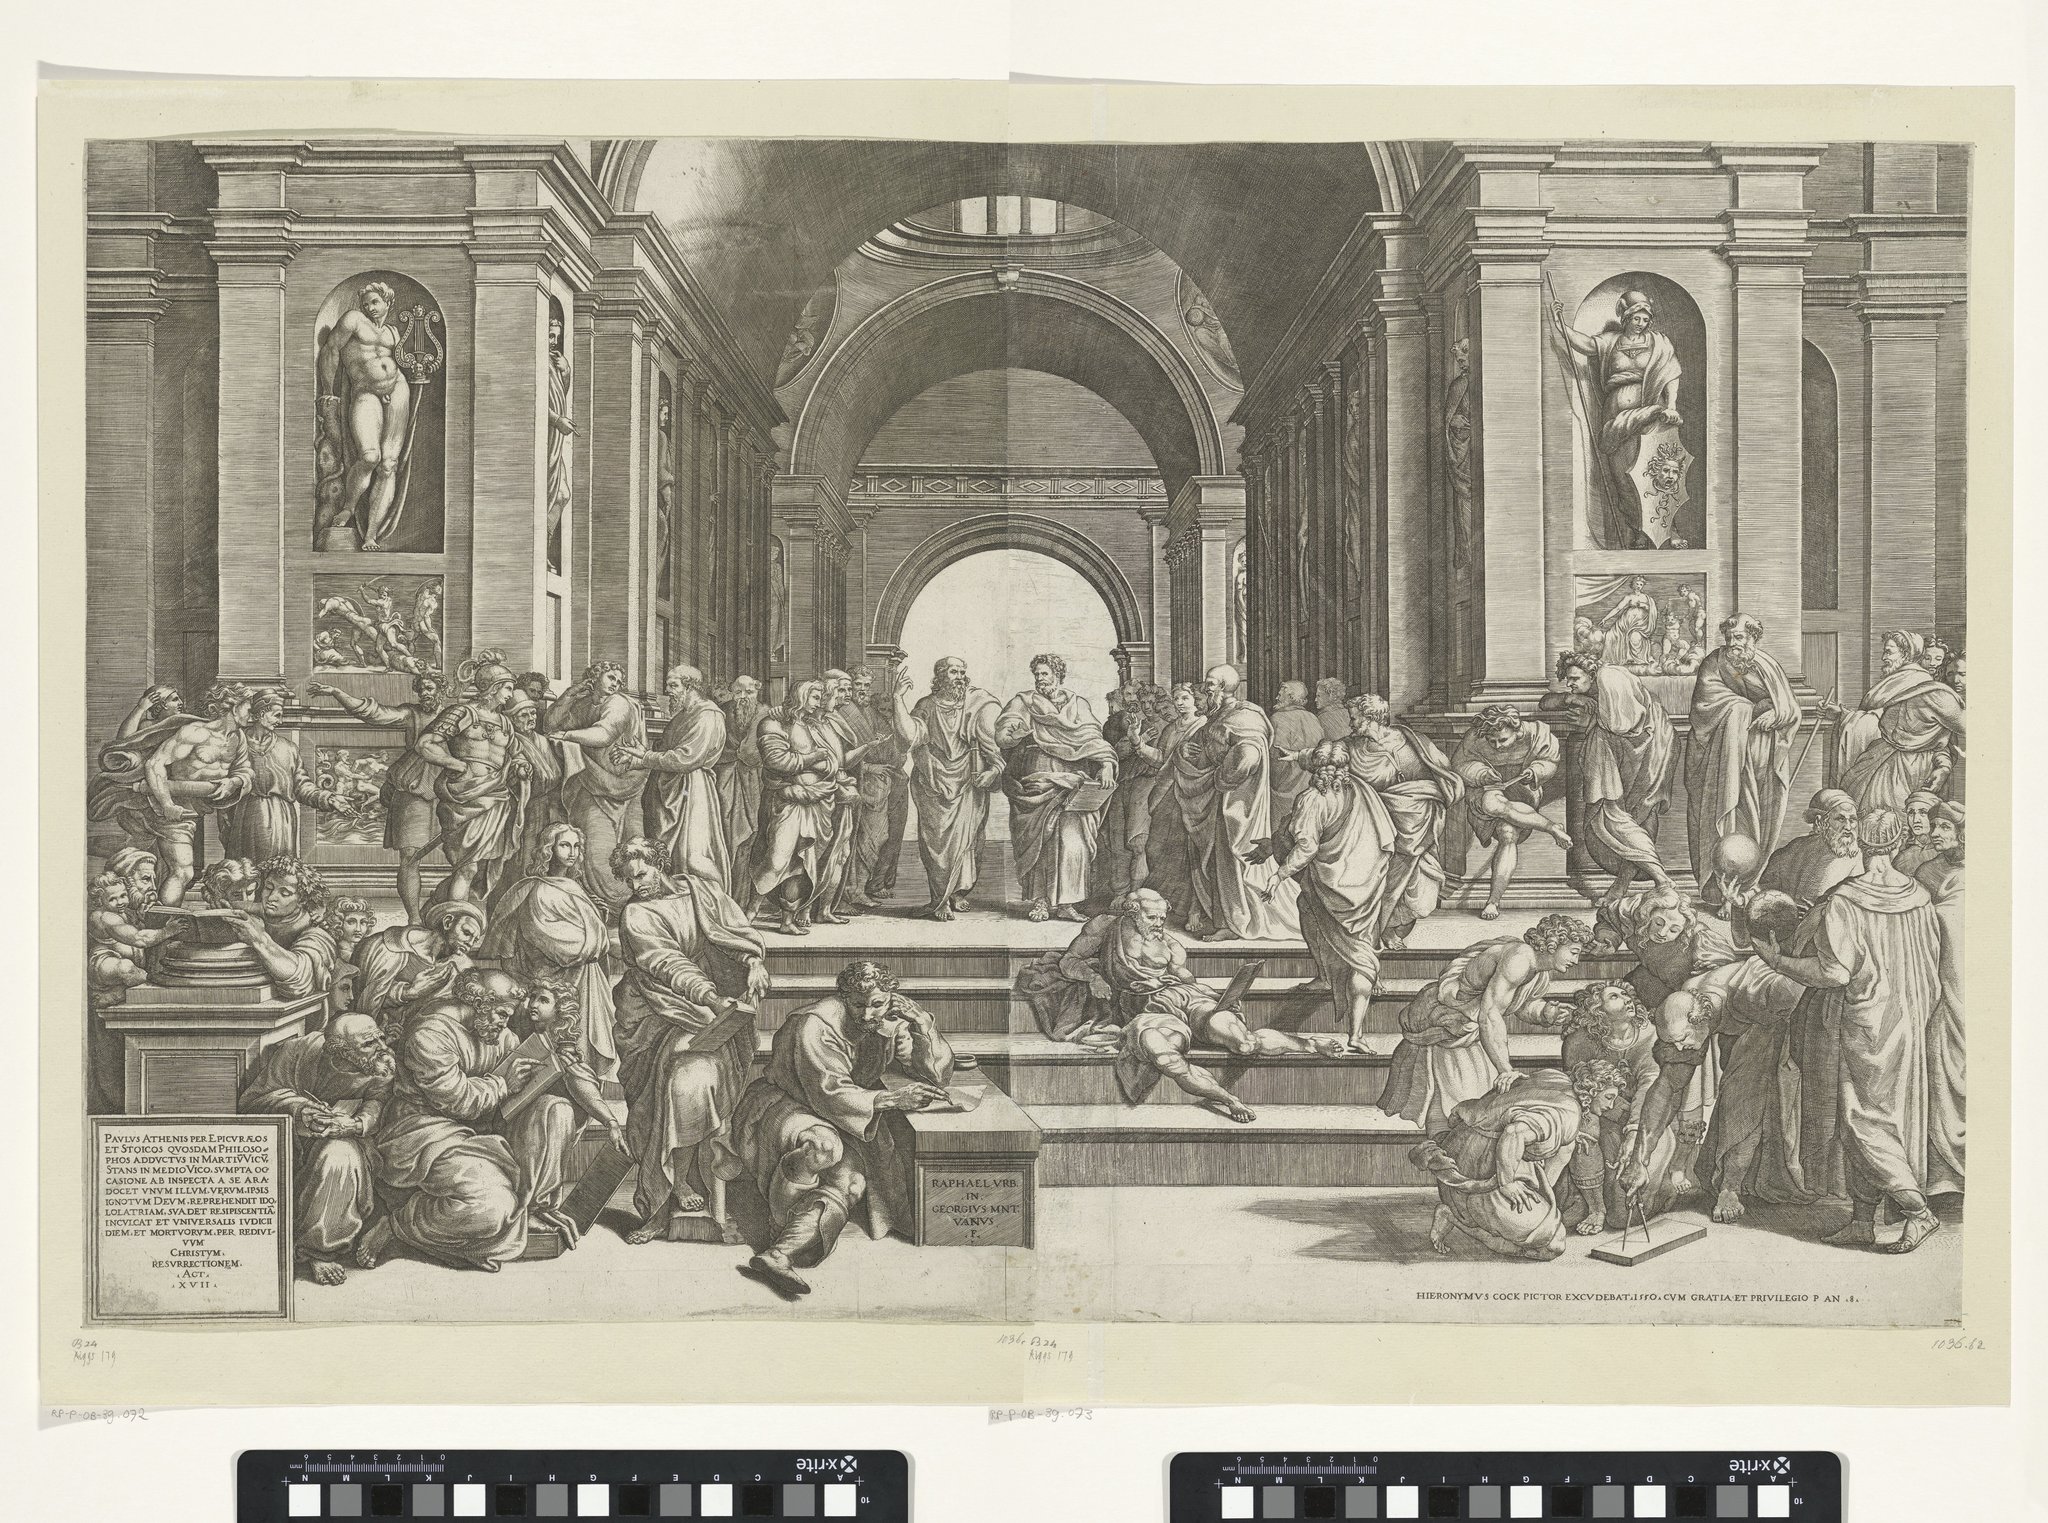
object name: print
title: De School van Athene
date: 1530-1582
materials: paper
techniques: engraving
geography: vatican city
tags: scholar, philosopher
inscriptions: collector's mark: Lugt 240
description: Het fresco 'De School van Athene' door Rafaël in de Stanza della Segnatura in het Apostolisch paleis in het Vaticaan. Het toont een filosofenschool of agora waar beroemde Griekse filosofen en geleerden, zoals Aristoteles, Plato en Socrates, in groepjes staan te praten. Het is een uitbeelding van de filosofie en haar rationele zoektocht naar de Waarheid.